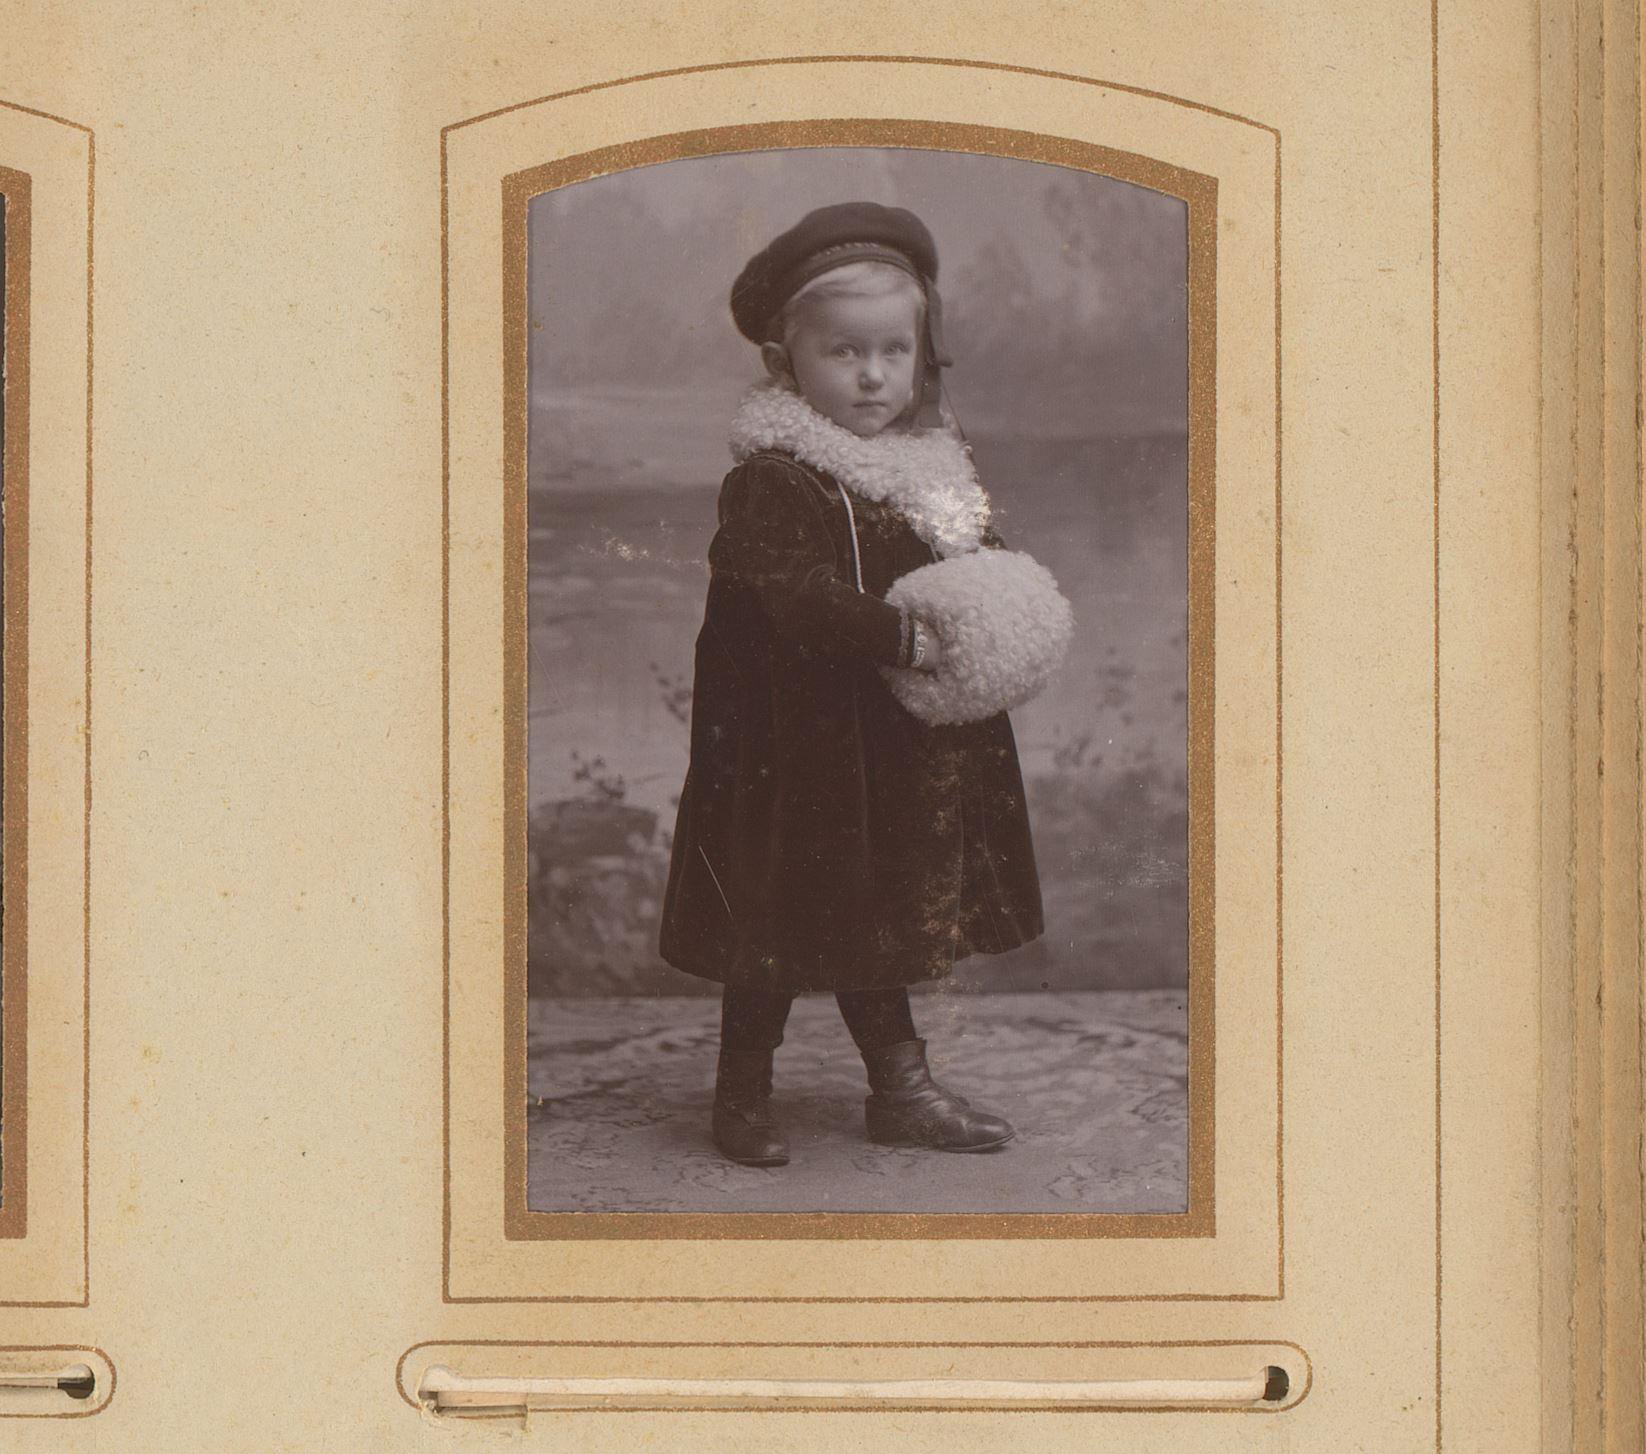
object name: album leaf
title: Portret van een staand kind met mof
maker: berend zweers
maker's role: fotograaf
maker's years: 1872-1946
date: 1923-1934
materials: cardboard, photographic support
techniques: collodion silver print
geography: haarlem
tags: child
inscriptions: inscription: ‘Berend Zweers/ Groote Houtstraat 174/ Haarlem’